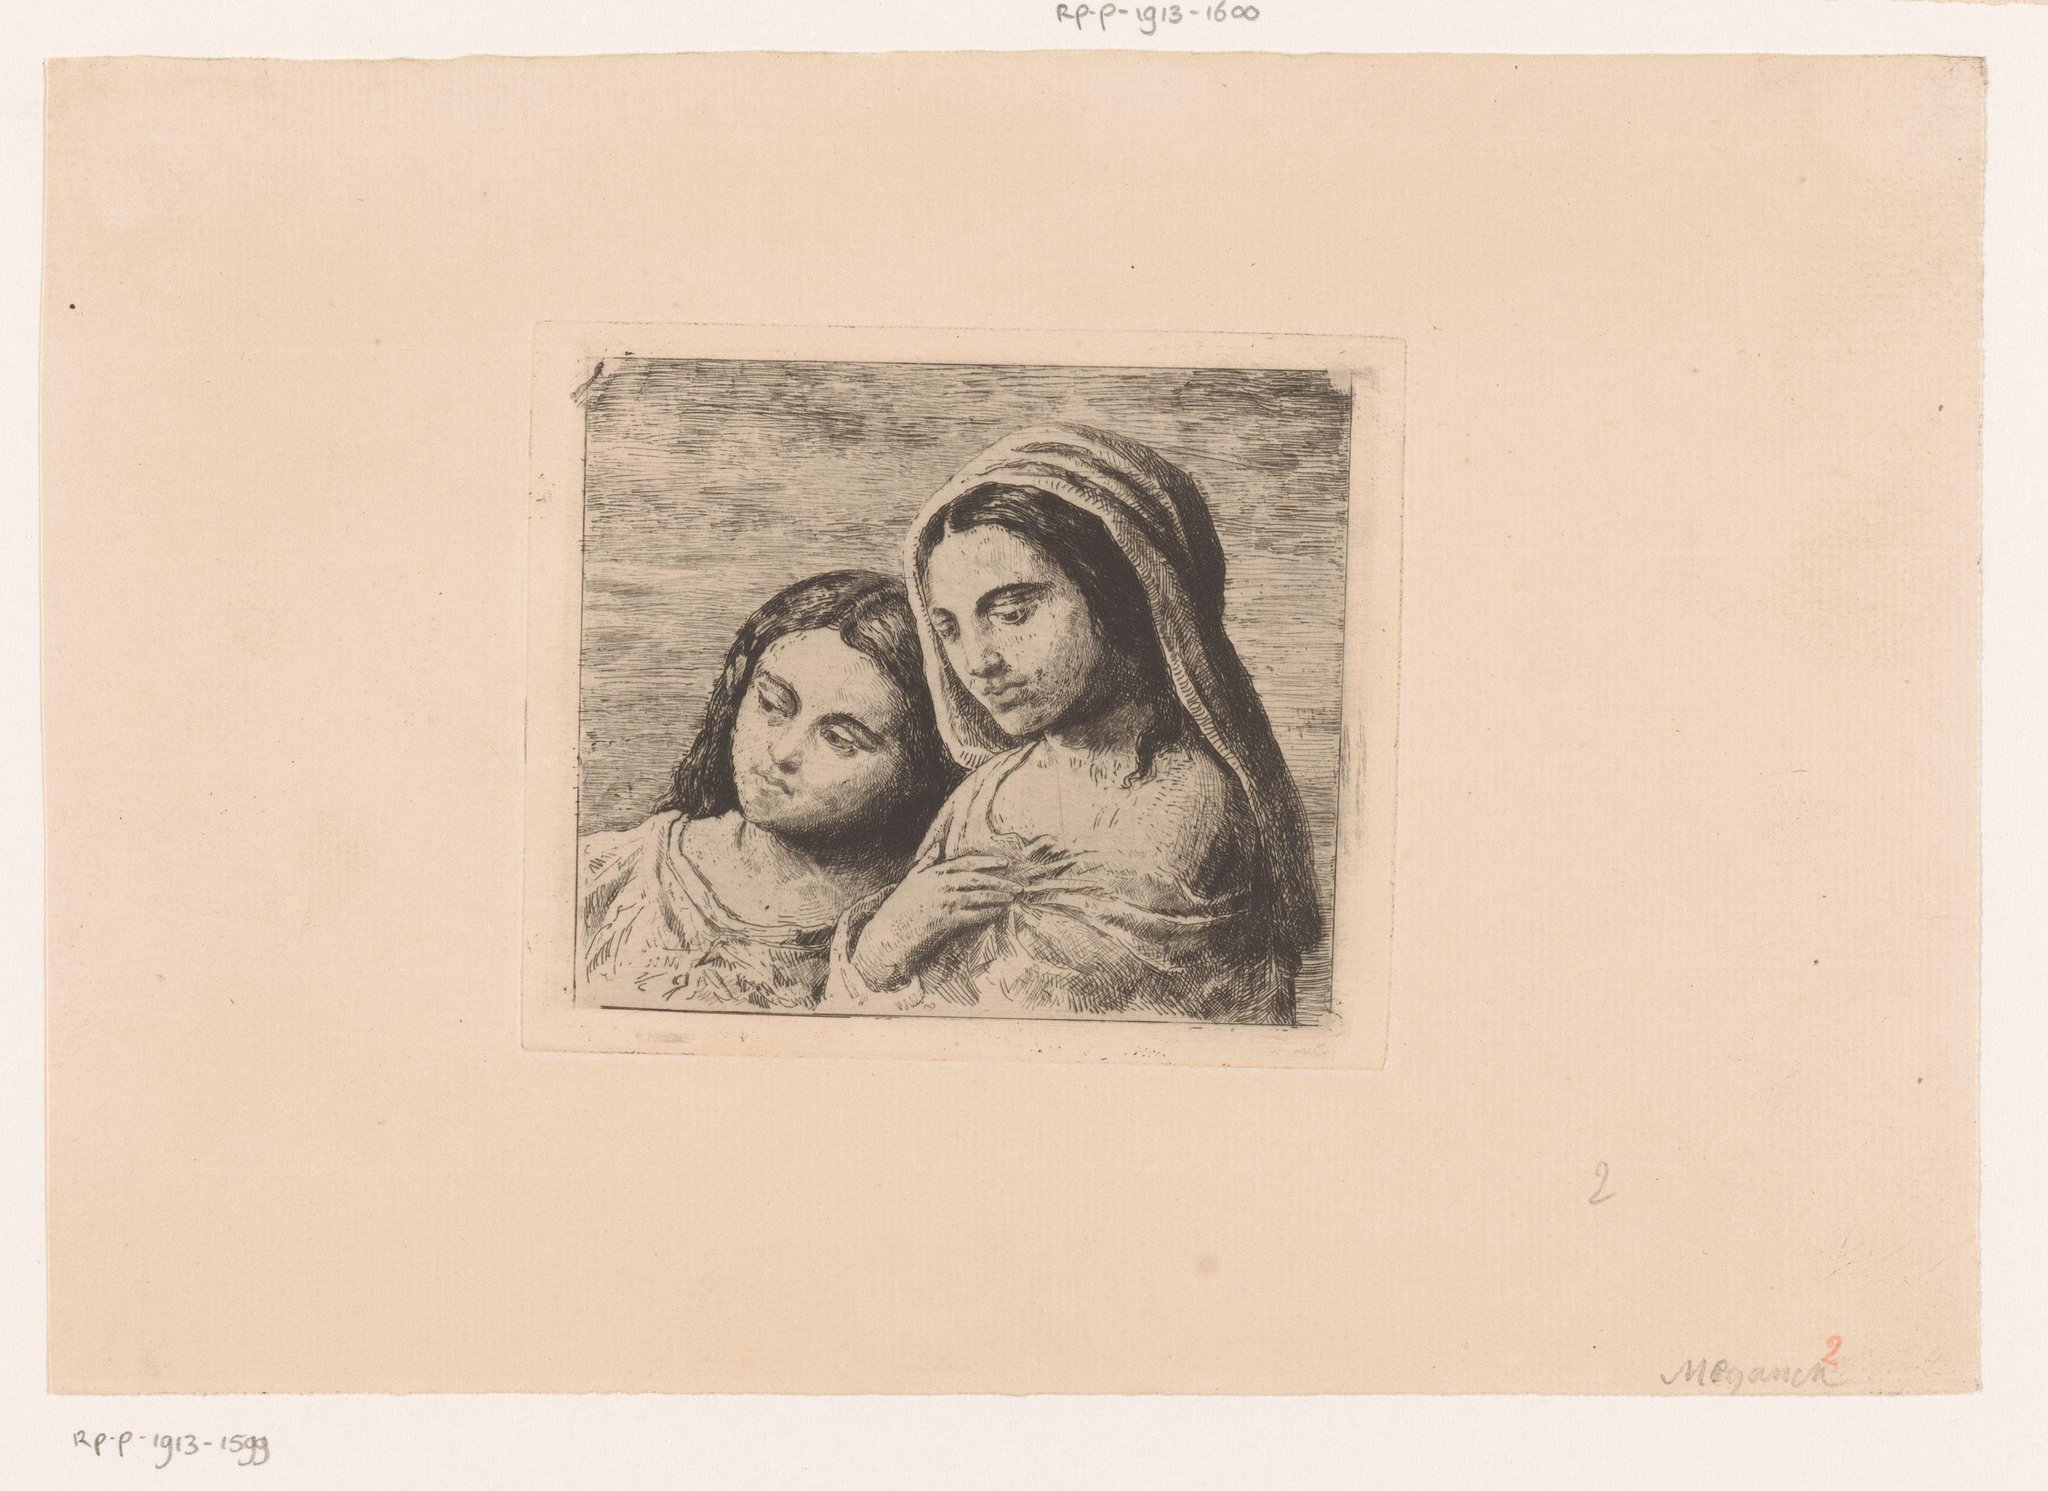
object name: print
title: Jonge vrouw en een meisje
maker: joseph meganck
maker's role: print maker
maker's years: 1807-1891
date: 1817-1891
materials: paper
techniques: etching, intaglio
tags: adolescent, young woman, maiden, girl (child between toddler and youth)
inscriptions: collector's mark: Lugt 2228